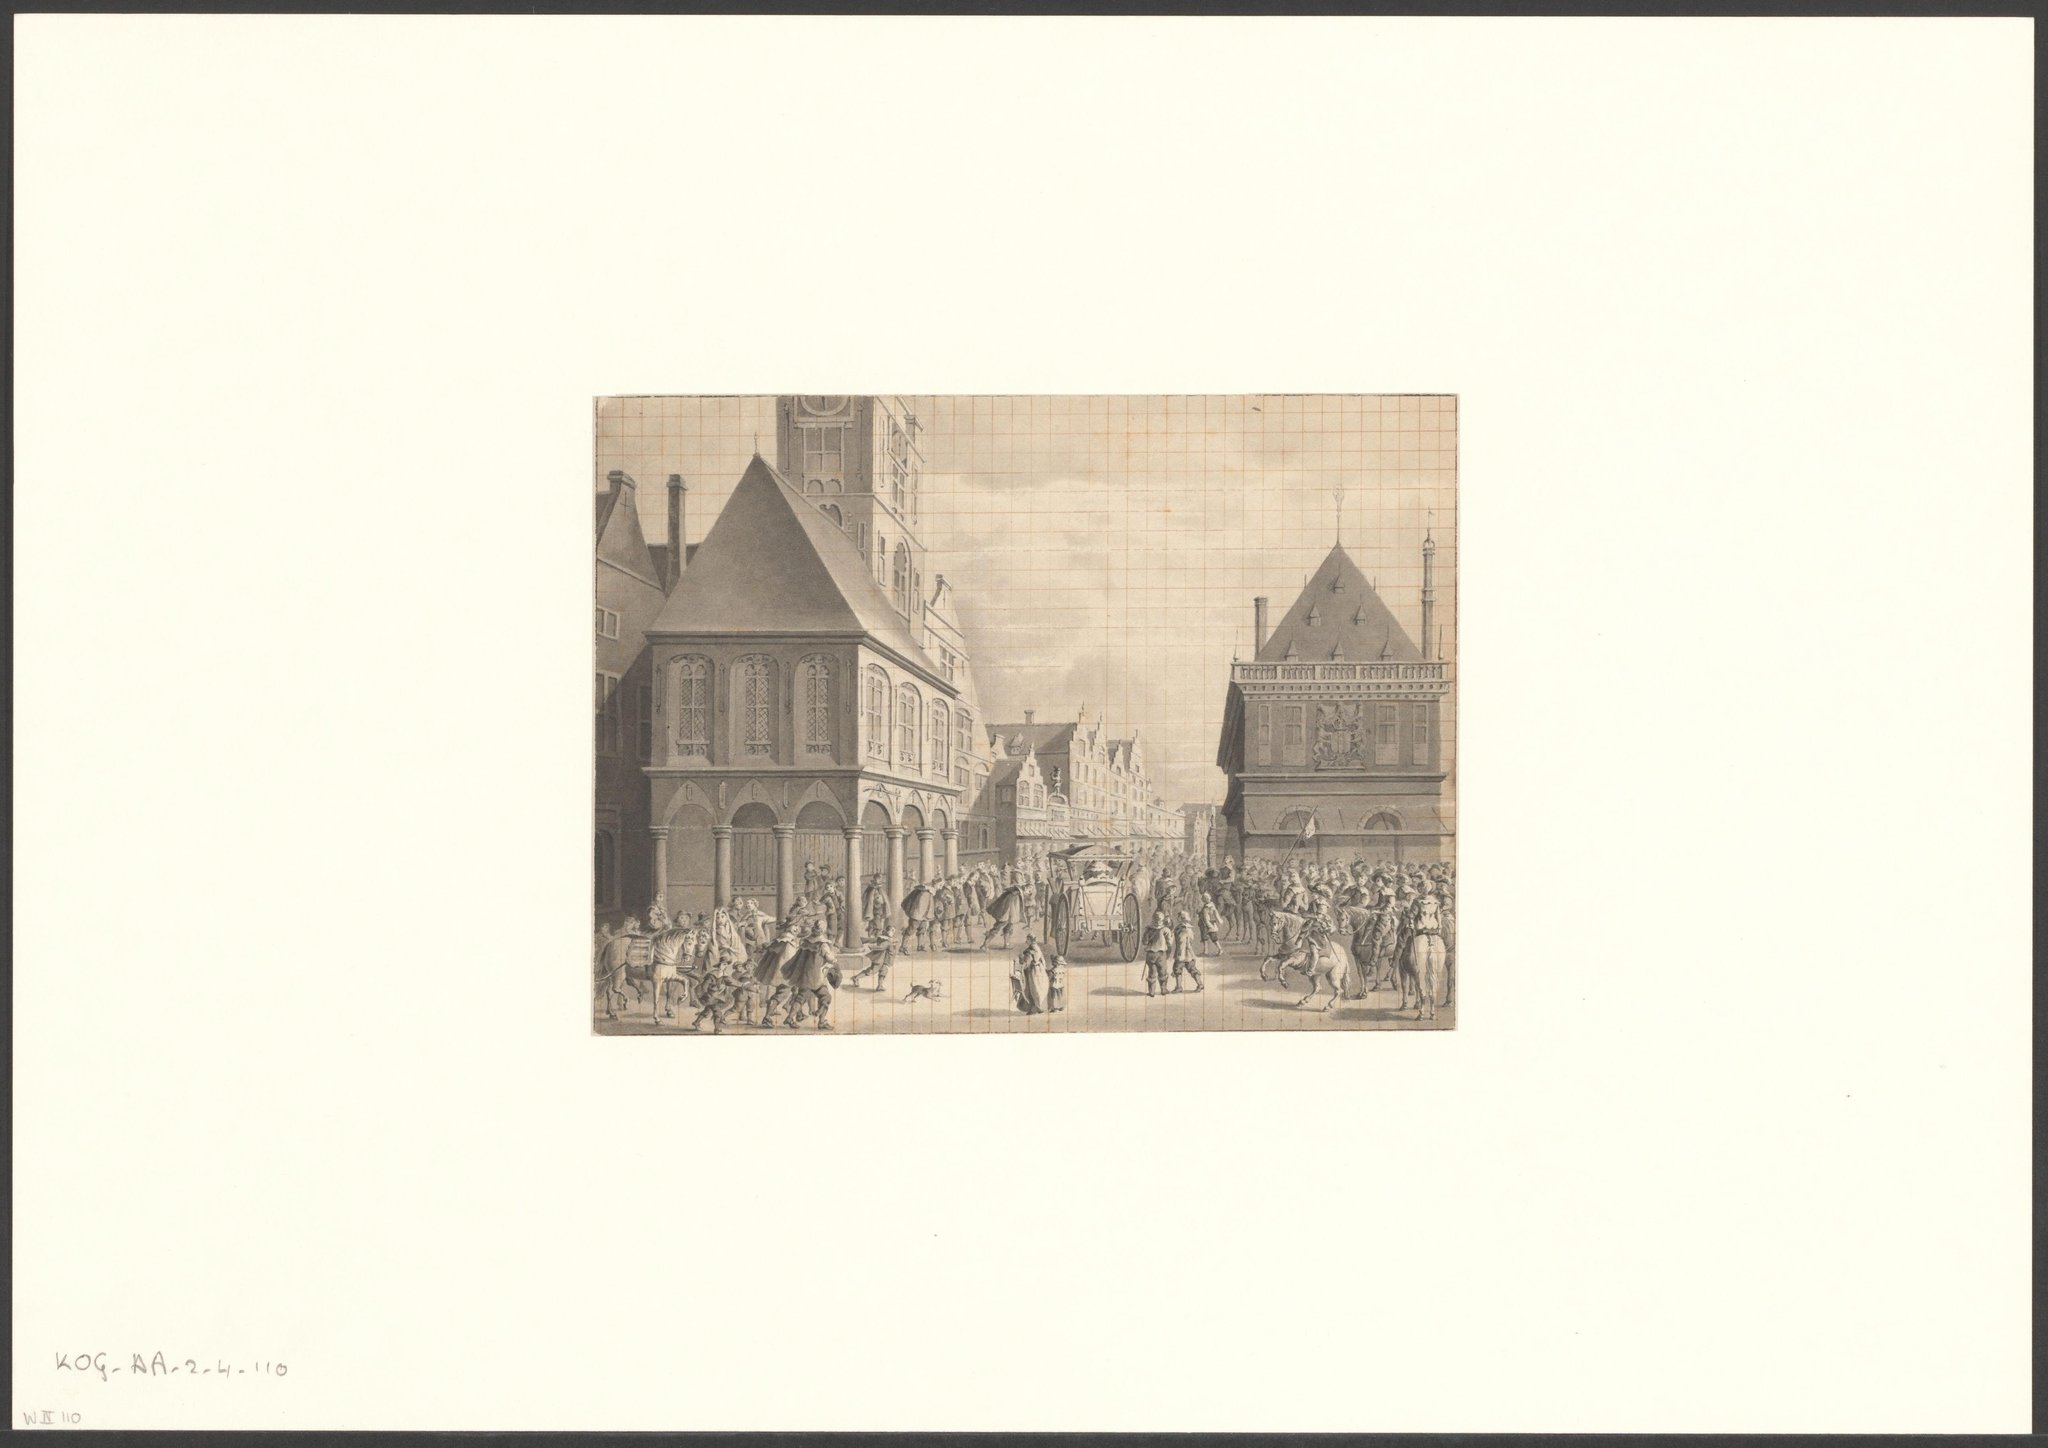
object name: drawing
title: Gezicht op de Dam met het oude stadhuis en de Waag met het vertrek van Maria de' Medici uit Amsterdam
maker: jan frederik christiaan reckleben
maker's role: print maker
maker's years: 1819-1879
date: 1867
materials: ink, paper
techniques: brush, pen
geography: amsterdam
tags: cologne, maria de' medici, city-view in general; 'veduta', townhall, village square, place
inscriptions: name: ‘J.Fr.C. Reckleben 1867’, collector's mark: Lugt 800a, inscription: ‘Vertrek van Maria de Medicis in Amsterdam 1638’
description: Tekening binnen de Atlas Van Eck ingedeeld op wijknummer 4.